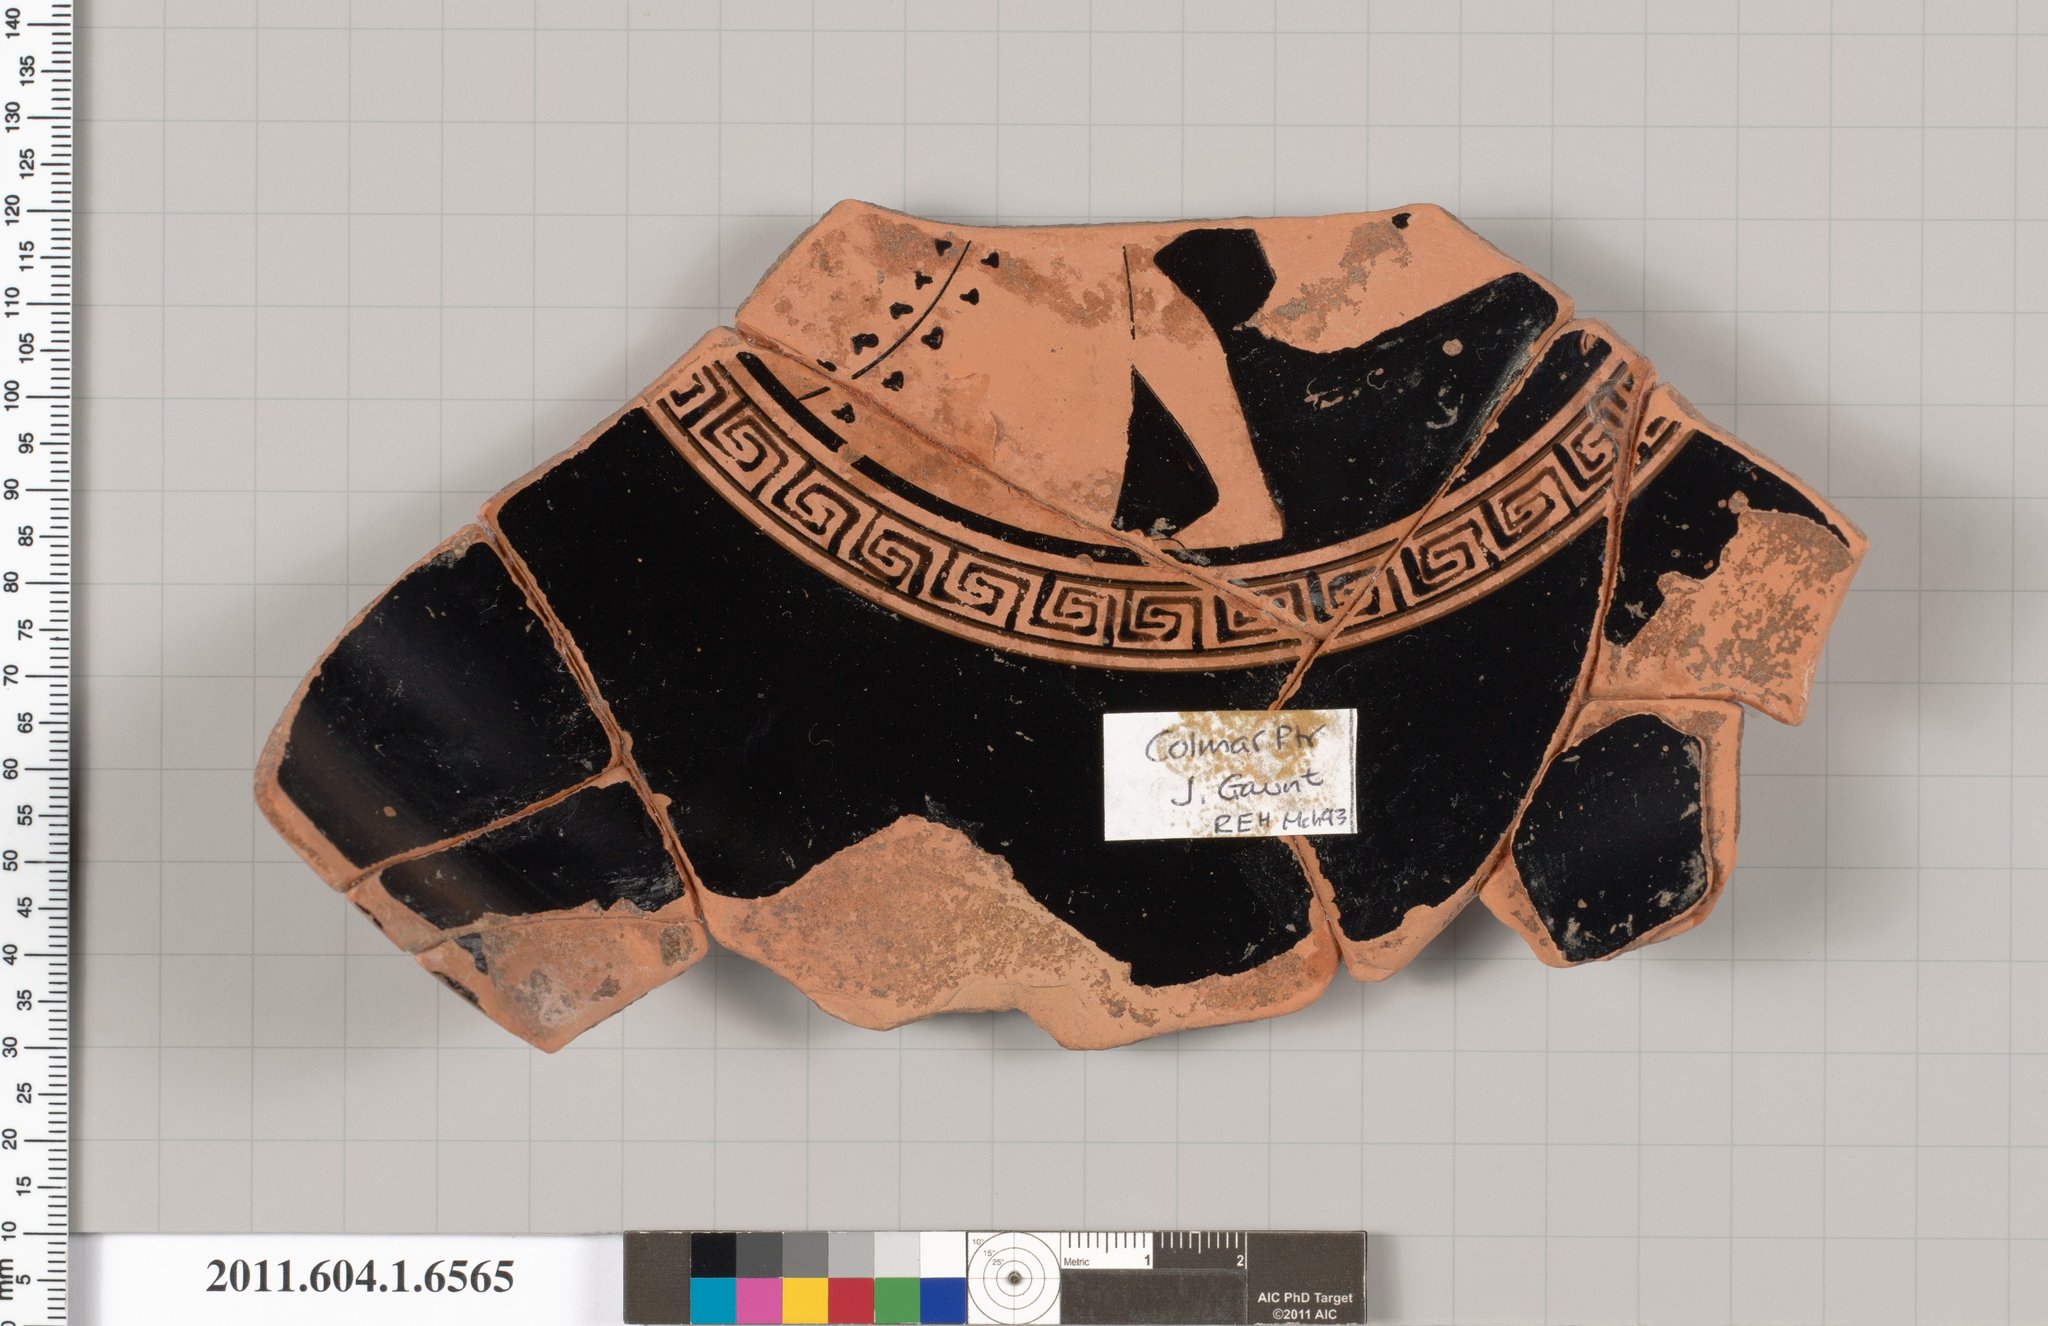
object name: kylix fragment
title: Terracotta fragment of a kylix (drinking cup)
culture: greek, attic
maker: colmar painter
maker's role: artist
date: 490-480 BCE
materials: terracotta